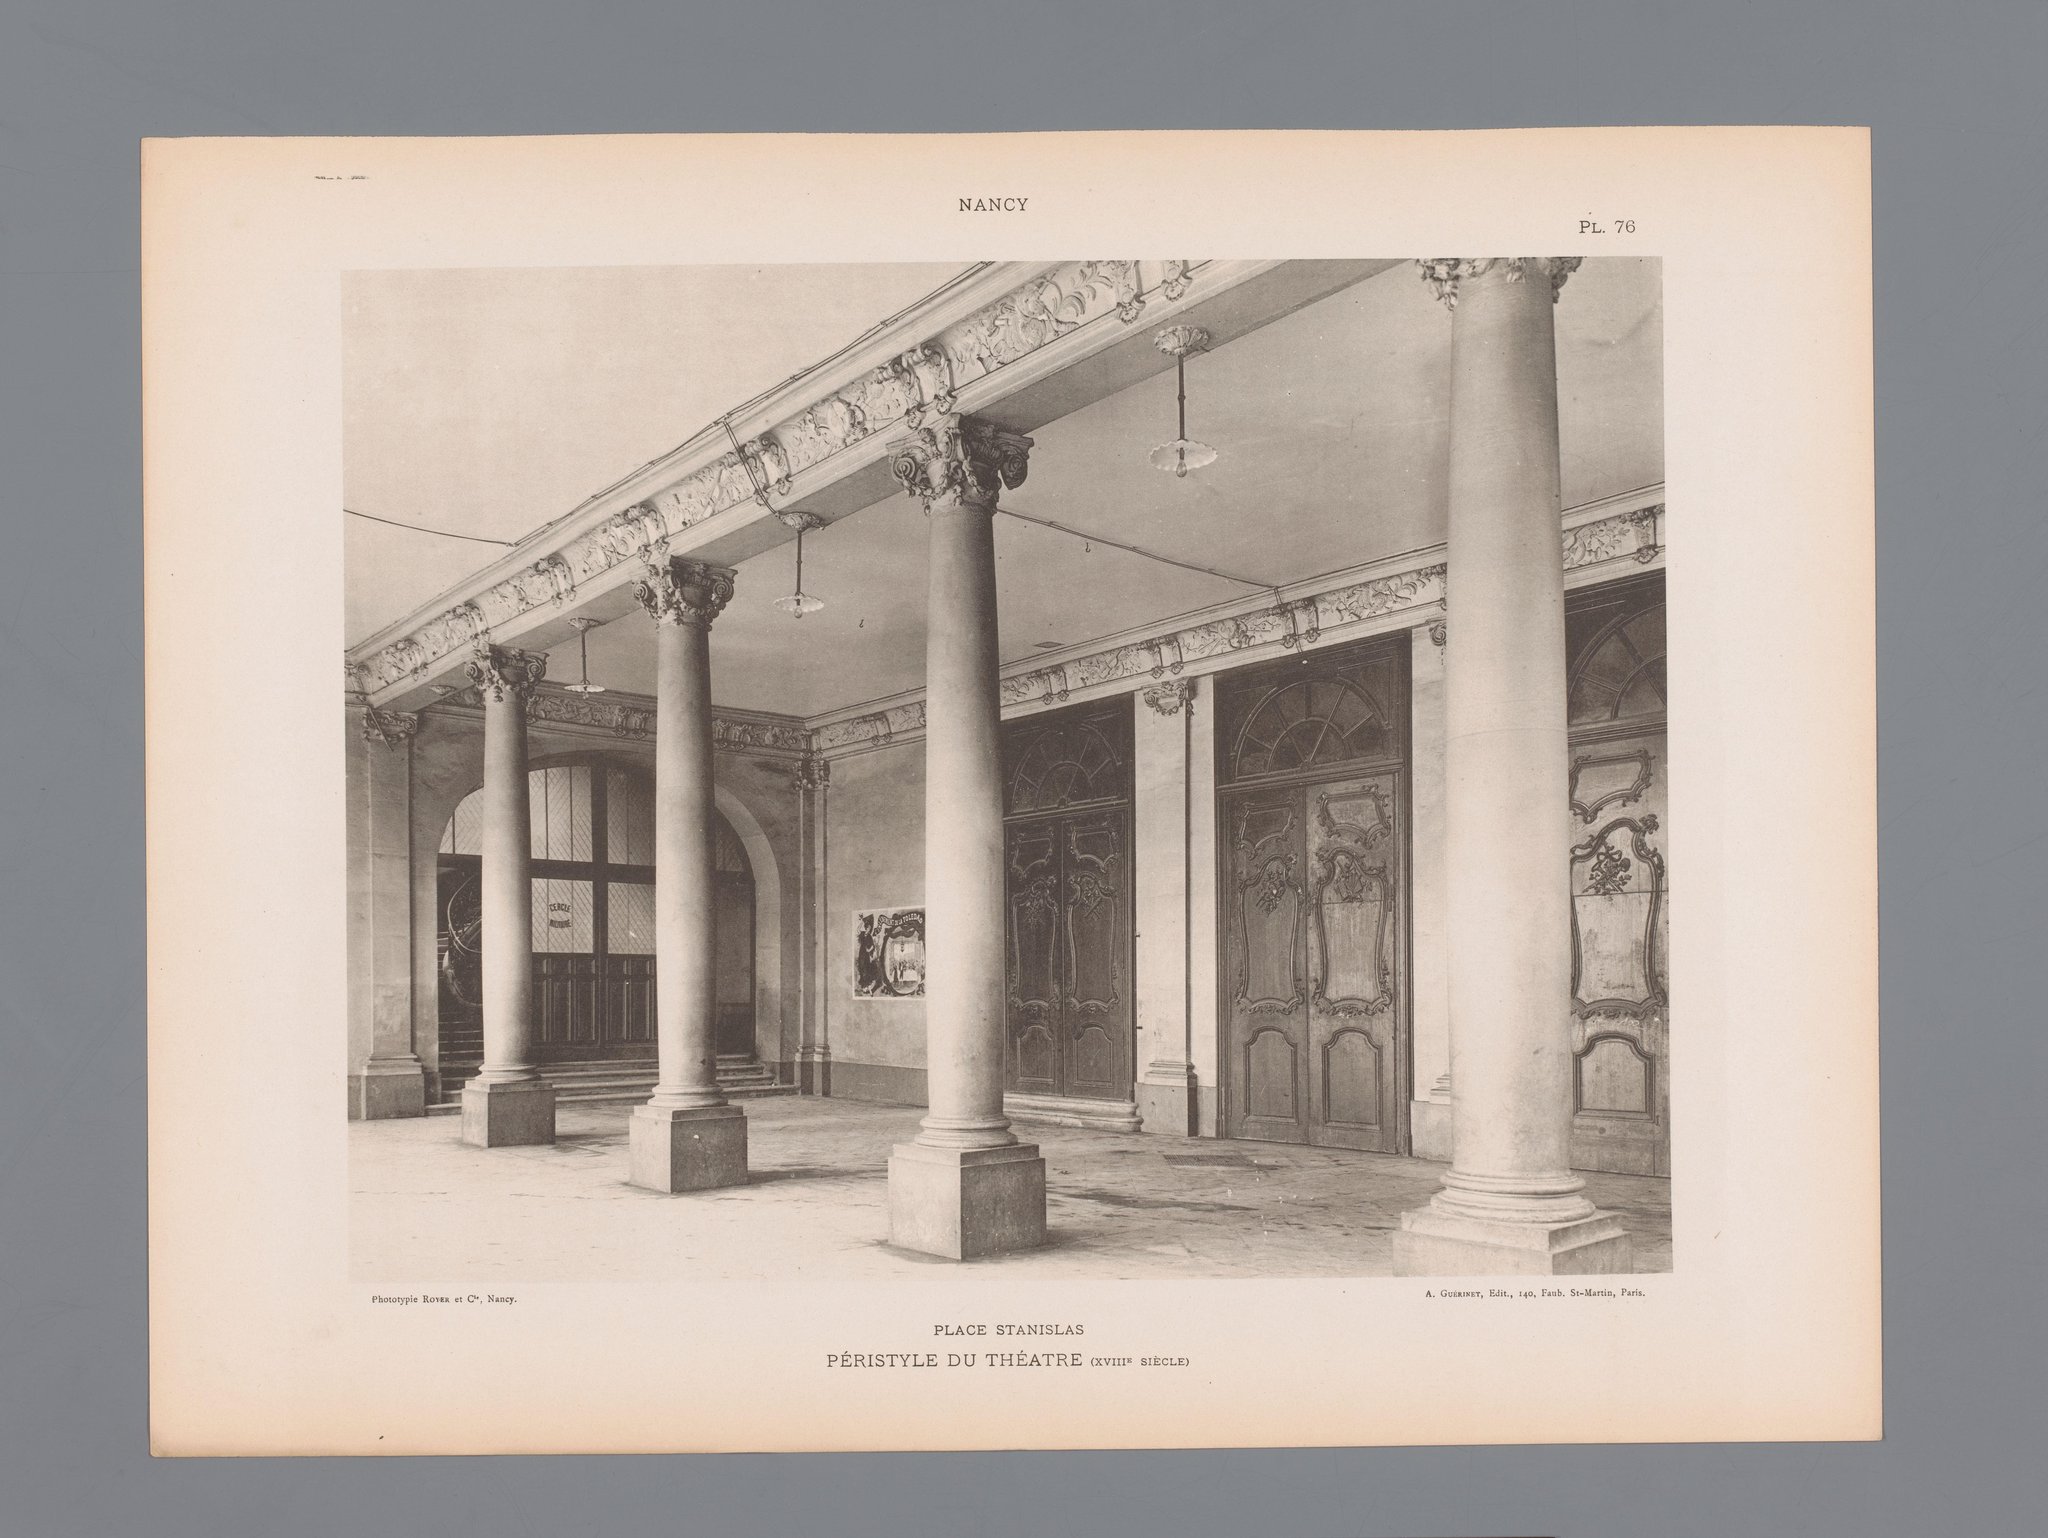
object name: photomechanical print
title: Zuilengalerij van het theater aan Place Stanislas te Nancy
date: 1891-1896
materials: paper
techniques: photograph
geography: paris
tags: colonnade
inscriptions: inscription: ‘Place Stanislas/ Péristyle du théatre (...)’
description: Deze prent maakt deel uit van een omslag met 103 prenten op 101 bladen en een titelblad.